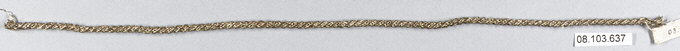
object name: cord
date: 1701-1900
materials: metal thread